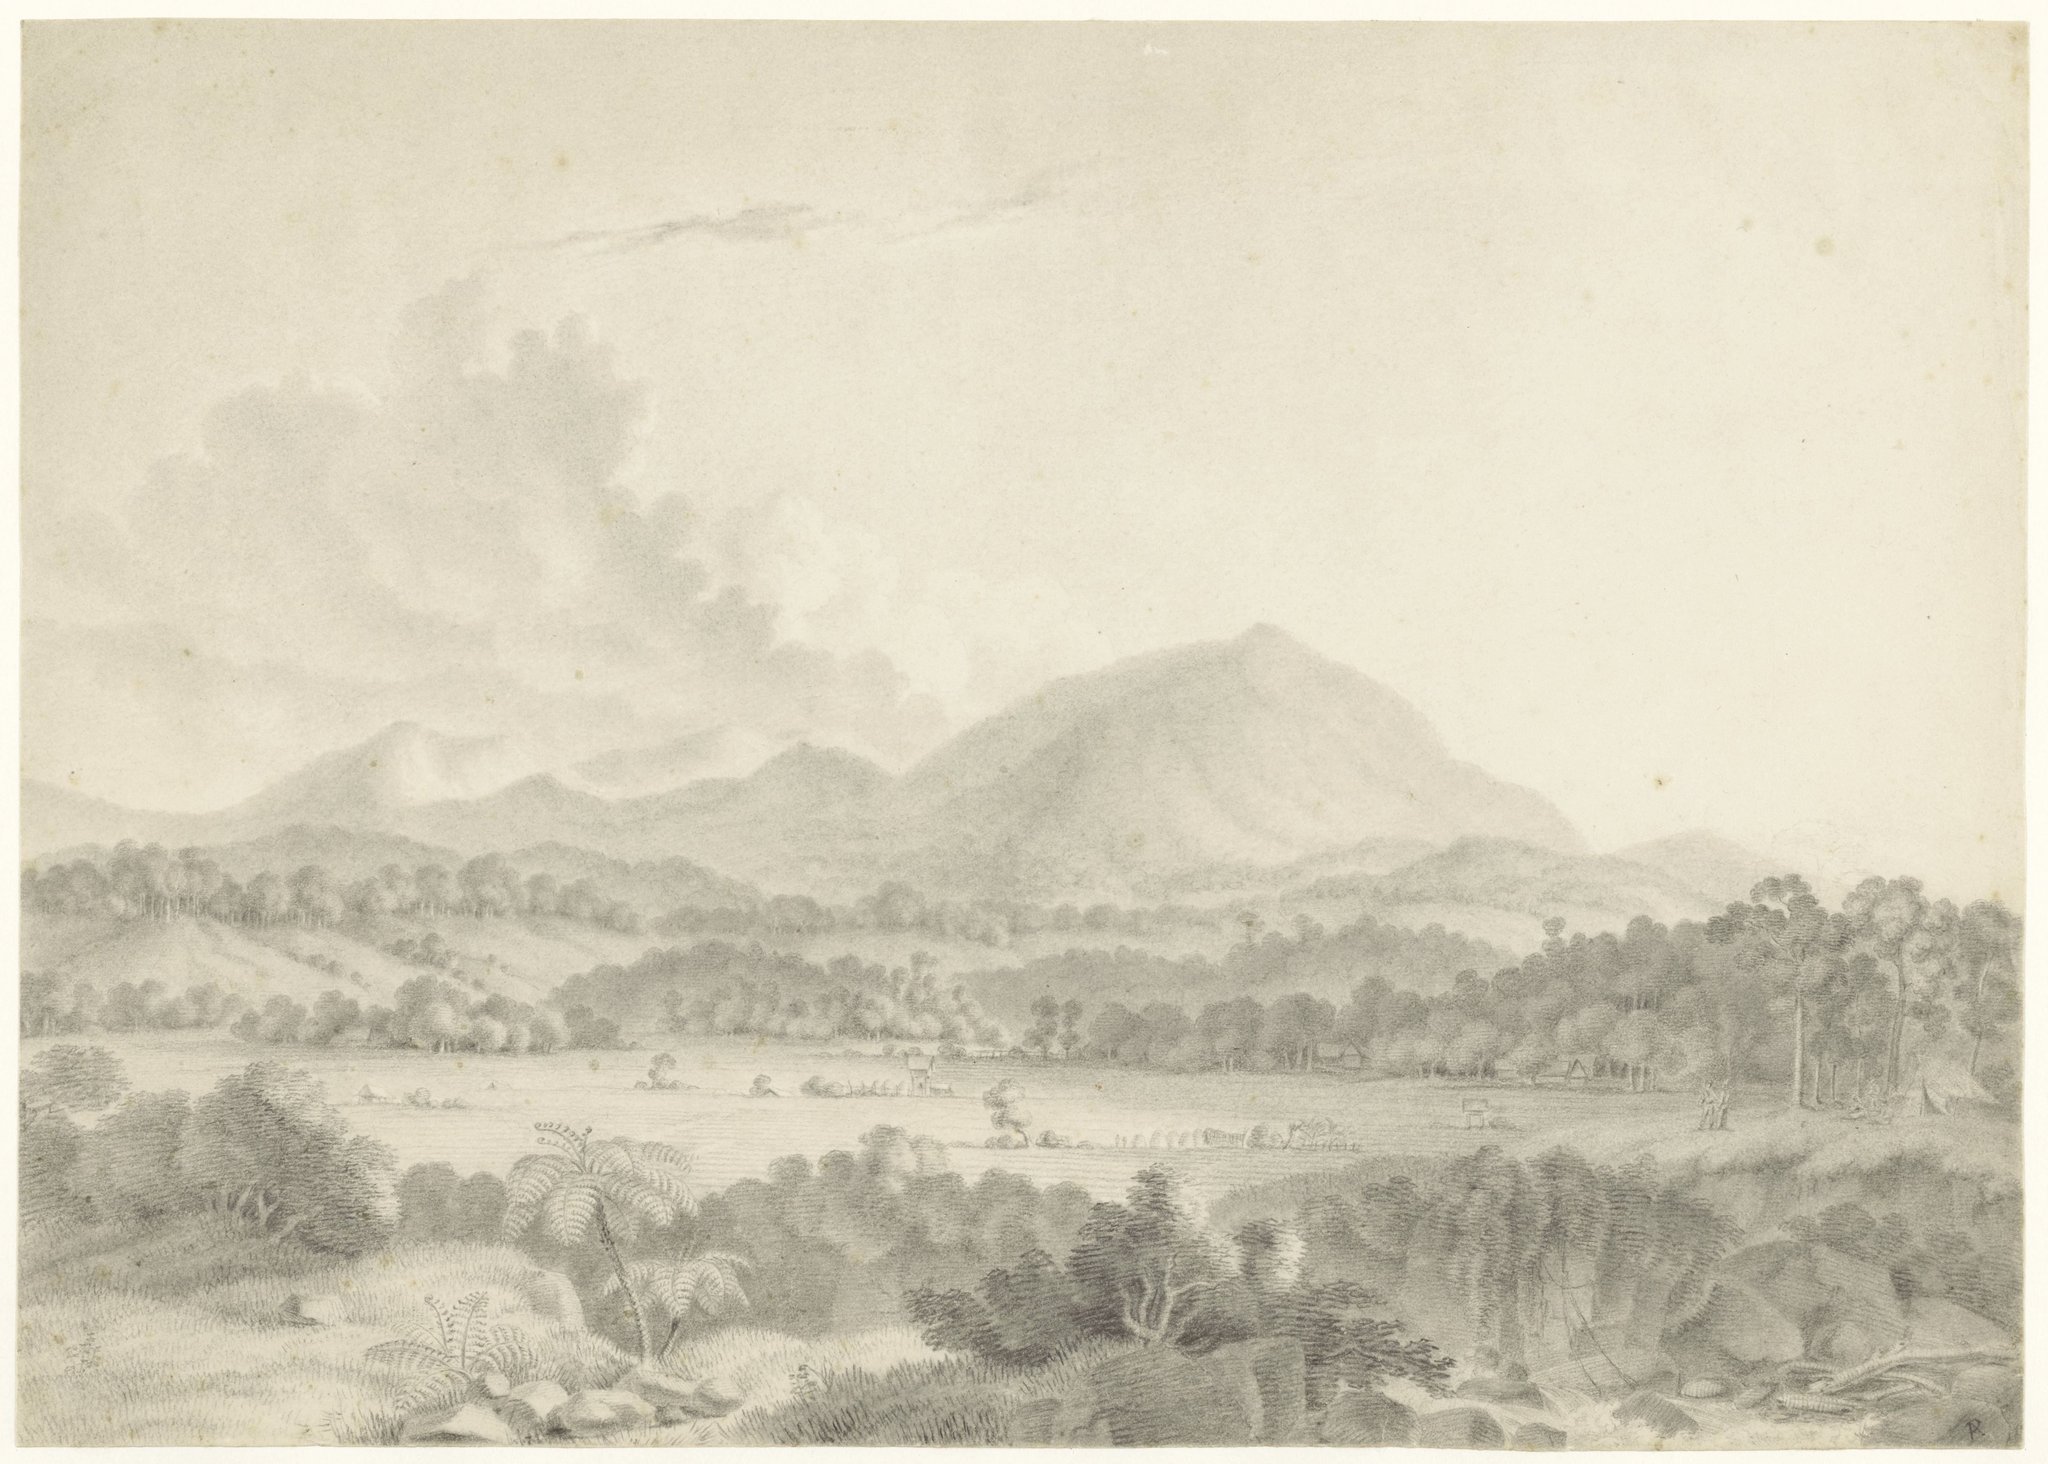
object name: drawing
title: Javaans landschap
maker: antoine auguste joseph payen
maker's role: draughtsman, painter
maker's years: 1792-1853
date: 1820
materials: chalk, paper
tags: mountains (in tropical and sub-tropical regions), java, indonesia